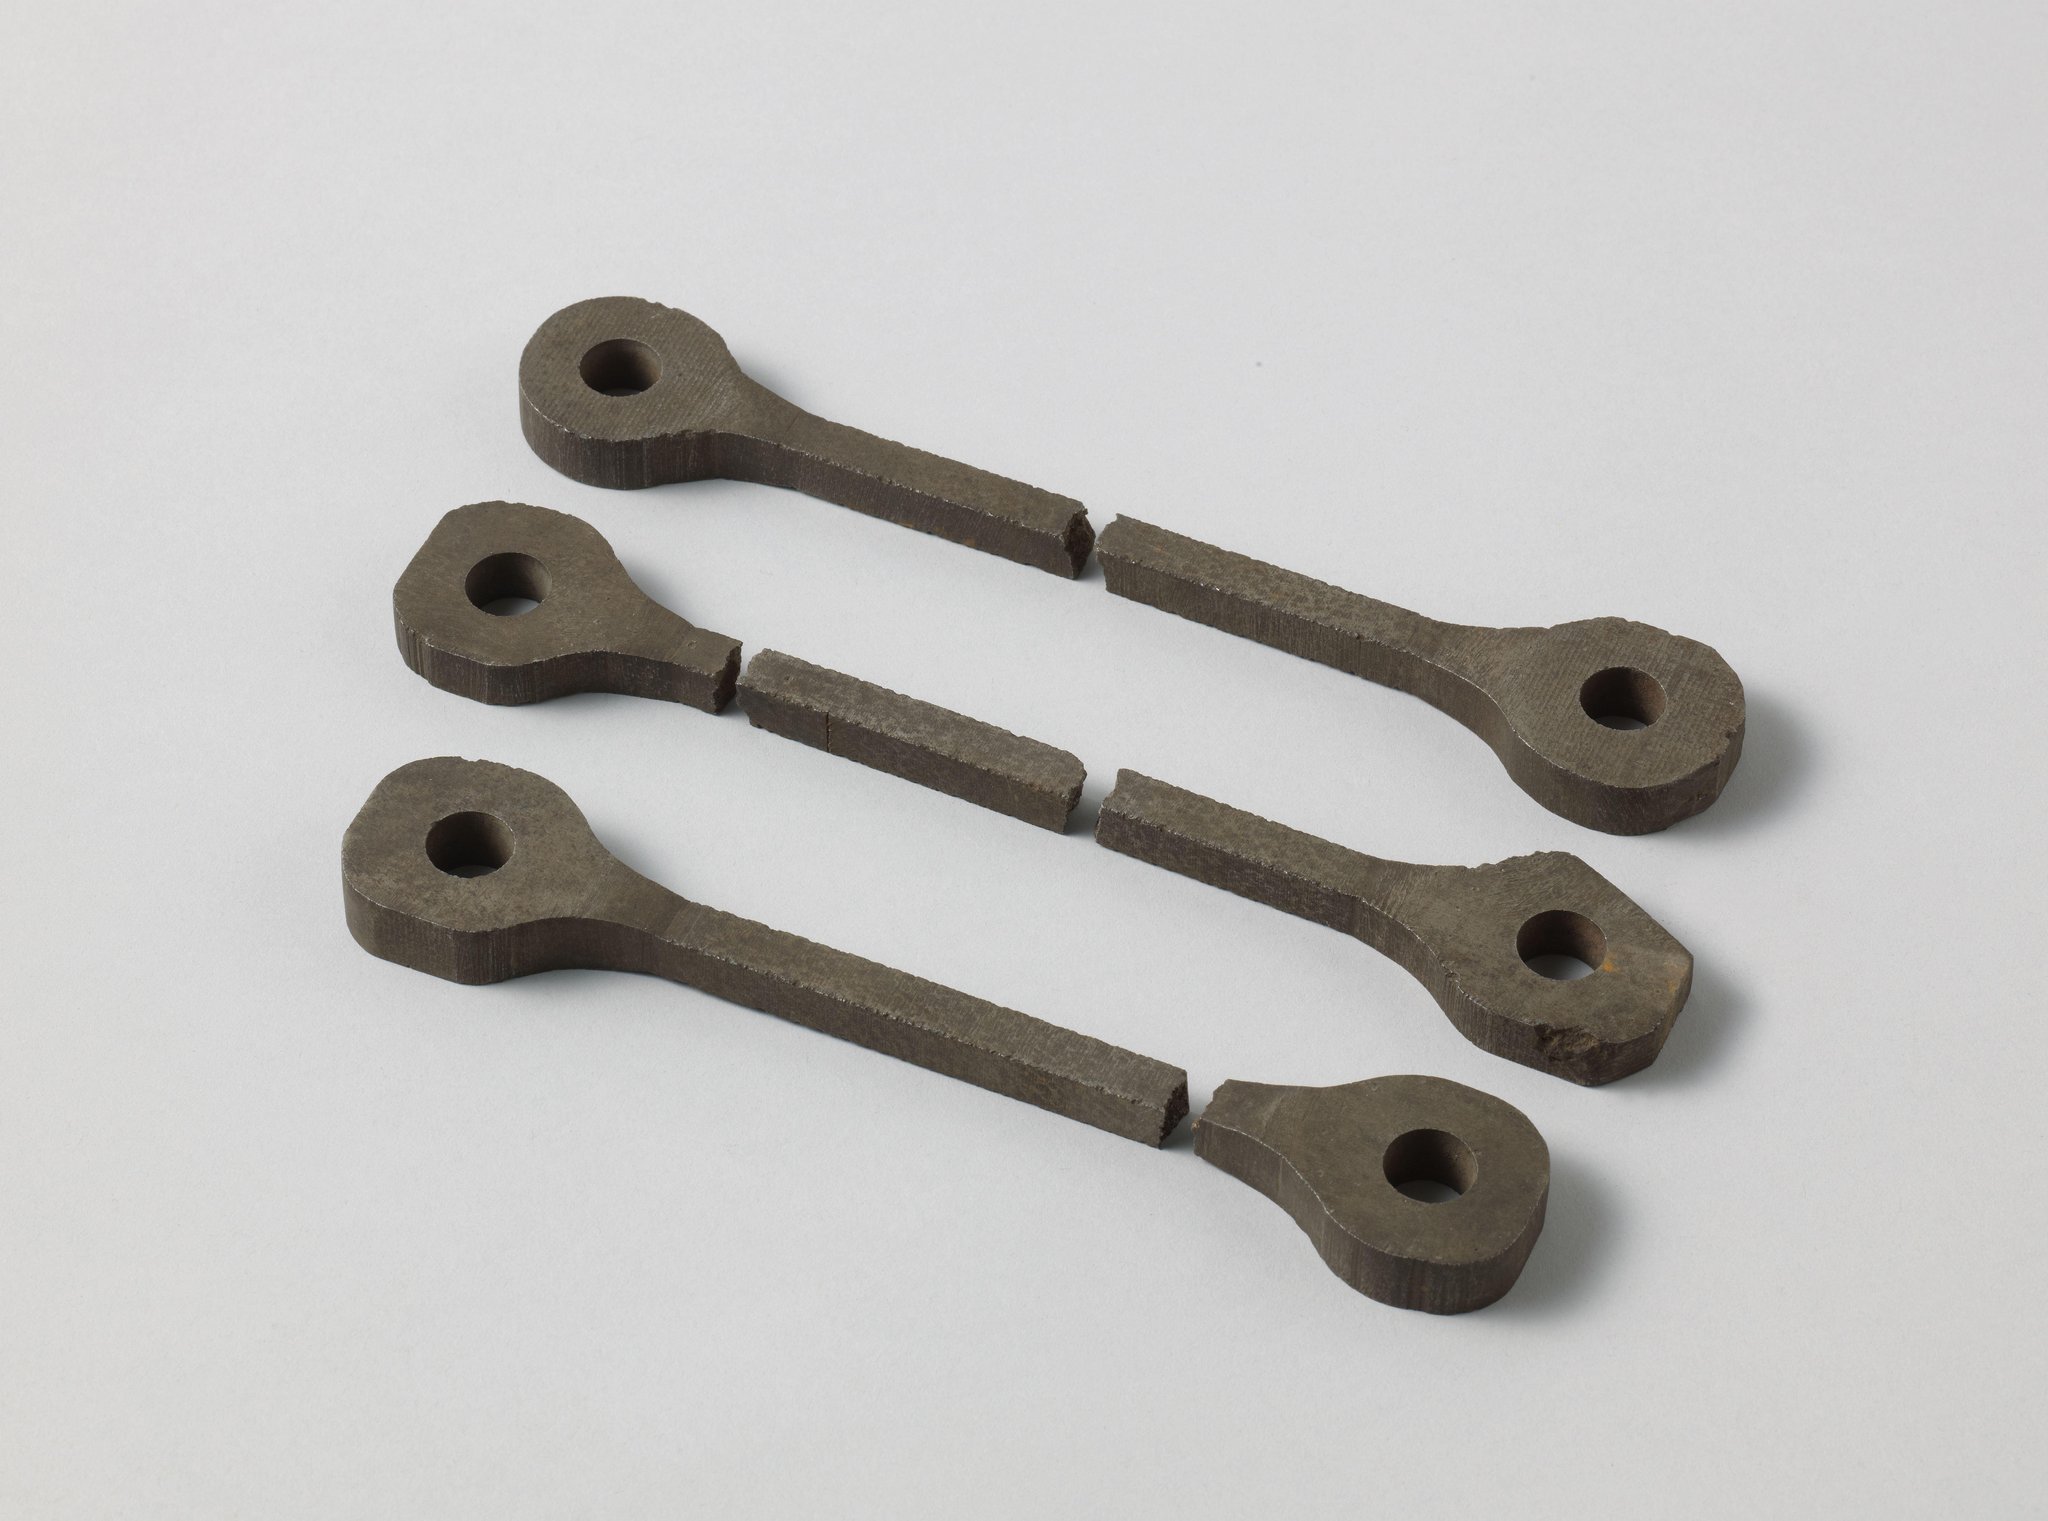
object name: sample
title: Cast-Iron Samples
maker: Anonymous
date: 1859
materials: iron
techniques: casting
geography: netherlands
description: Drie ijzermonsters van gietijzer, alle gebroken, één incompleet. Ze hebben alle de vorm van een kruk, dun in het midden en met wijde uiteinden met een gat erin. Eén proefstaaf is in tweeën gebroken, de tweede in drie stukken en de derde ook in drie, maar het tussenstuk daarvan ontbreekt.